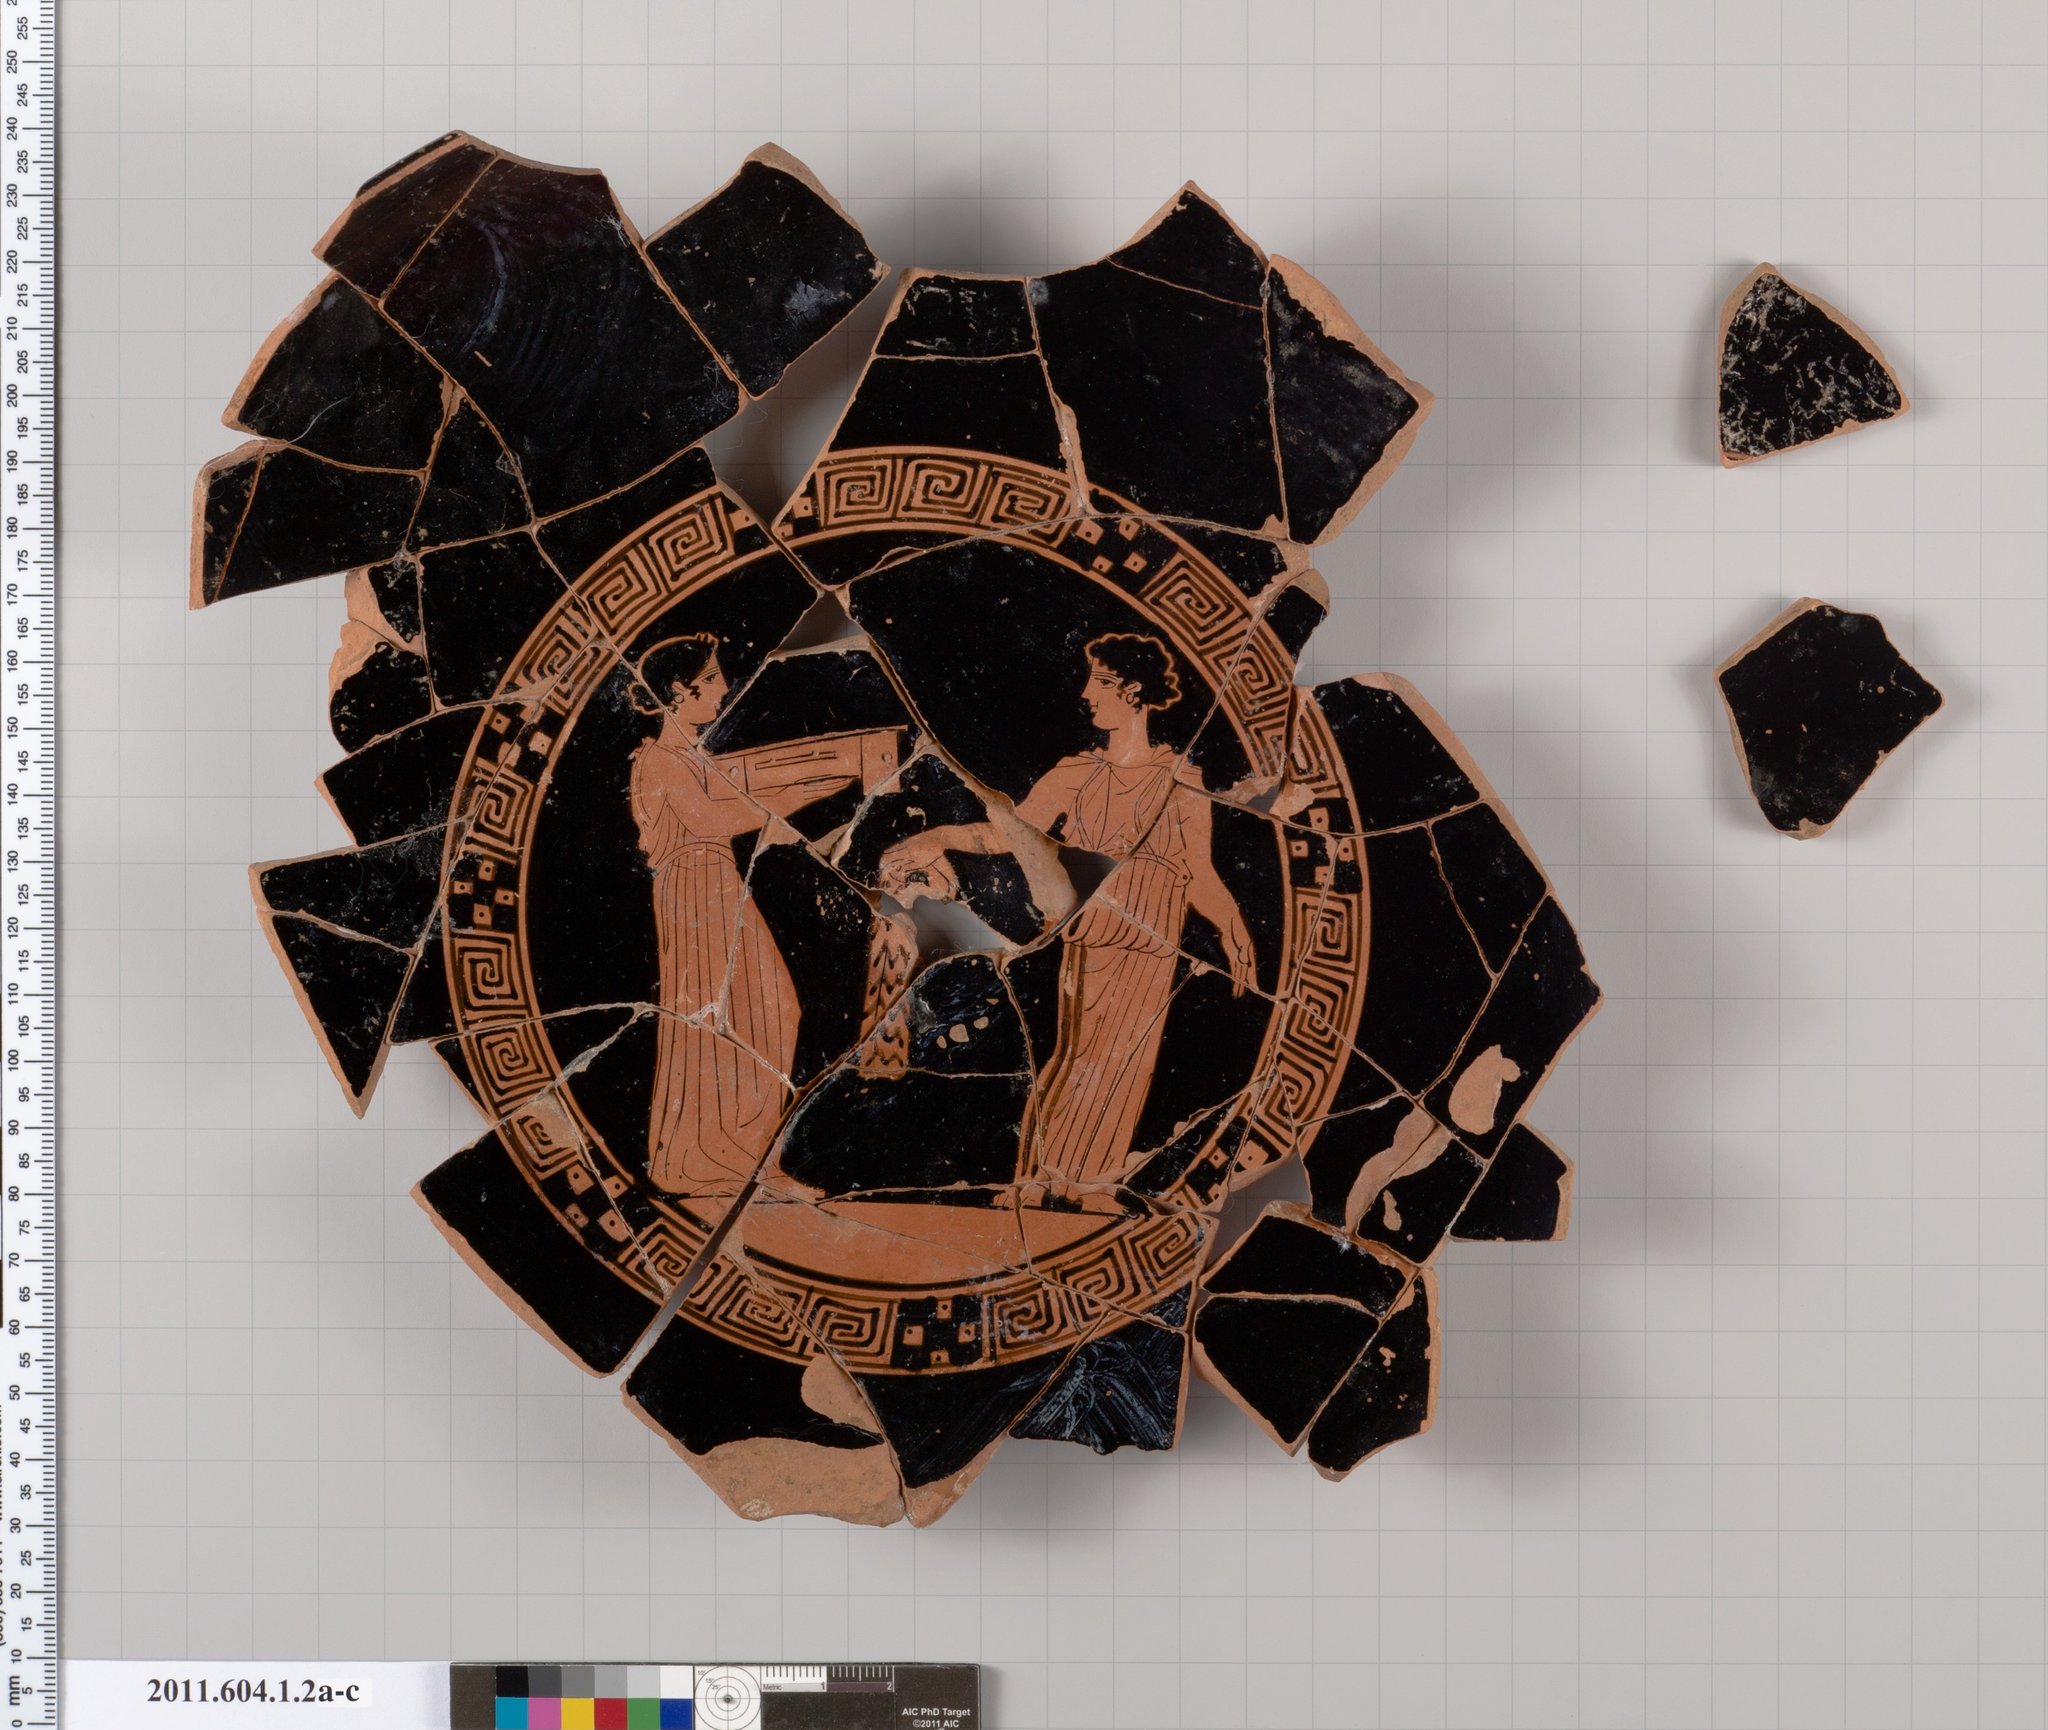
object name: kylix fragment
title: Terracotta fragments of a kylix (drinking cup)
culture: greek, attic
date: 467-435 BCE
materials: terracotta